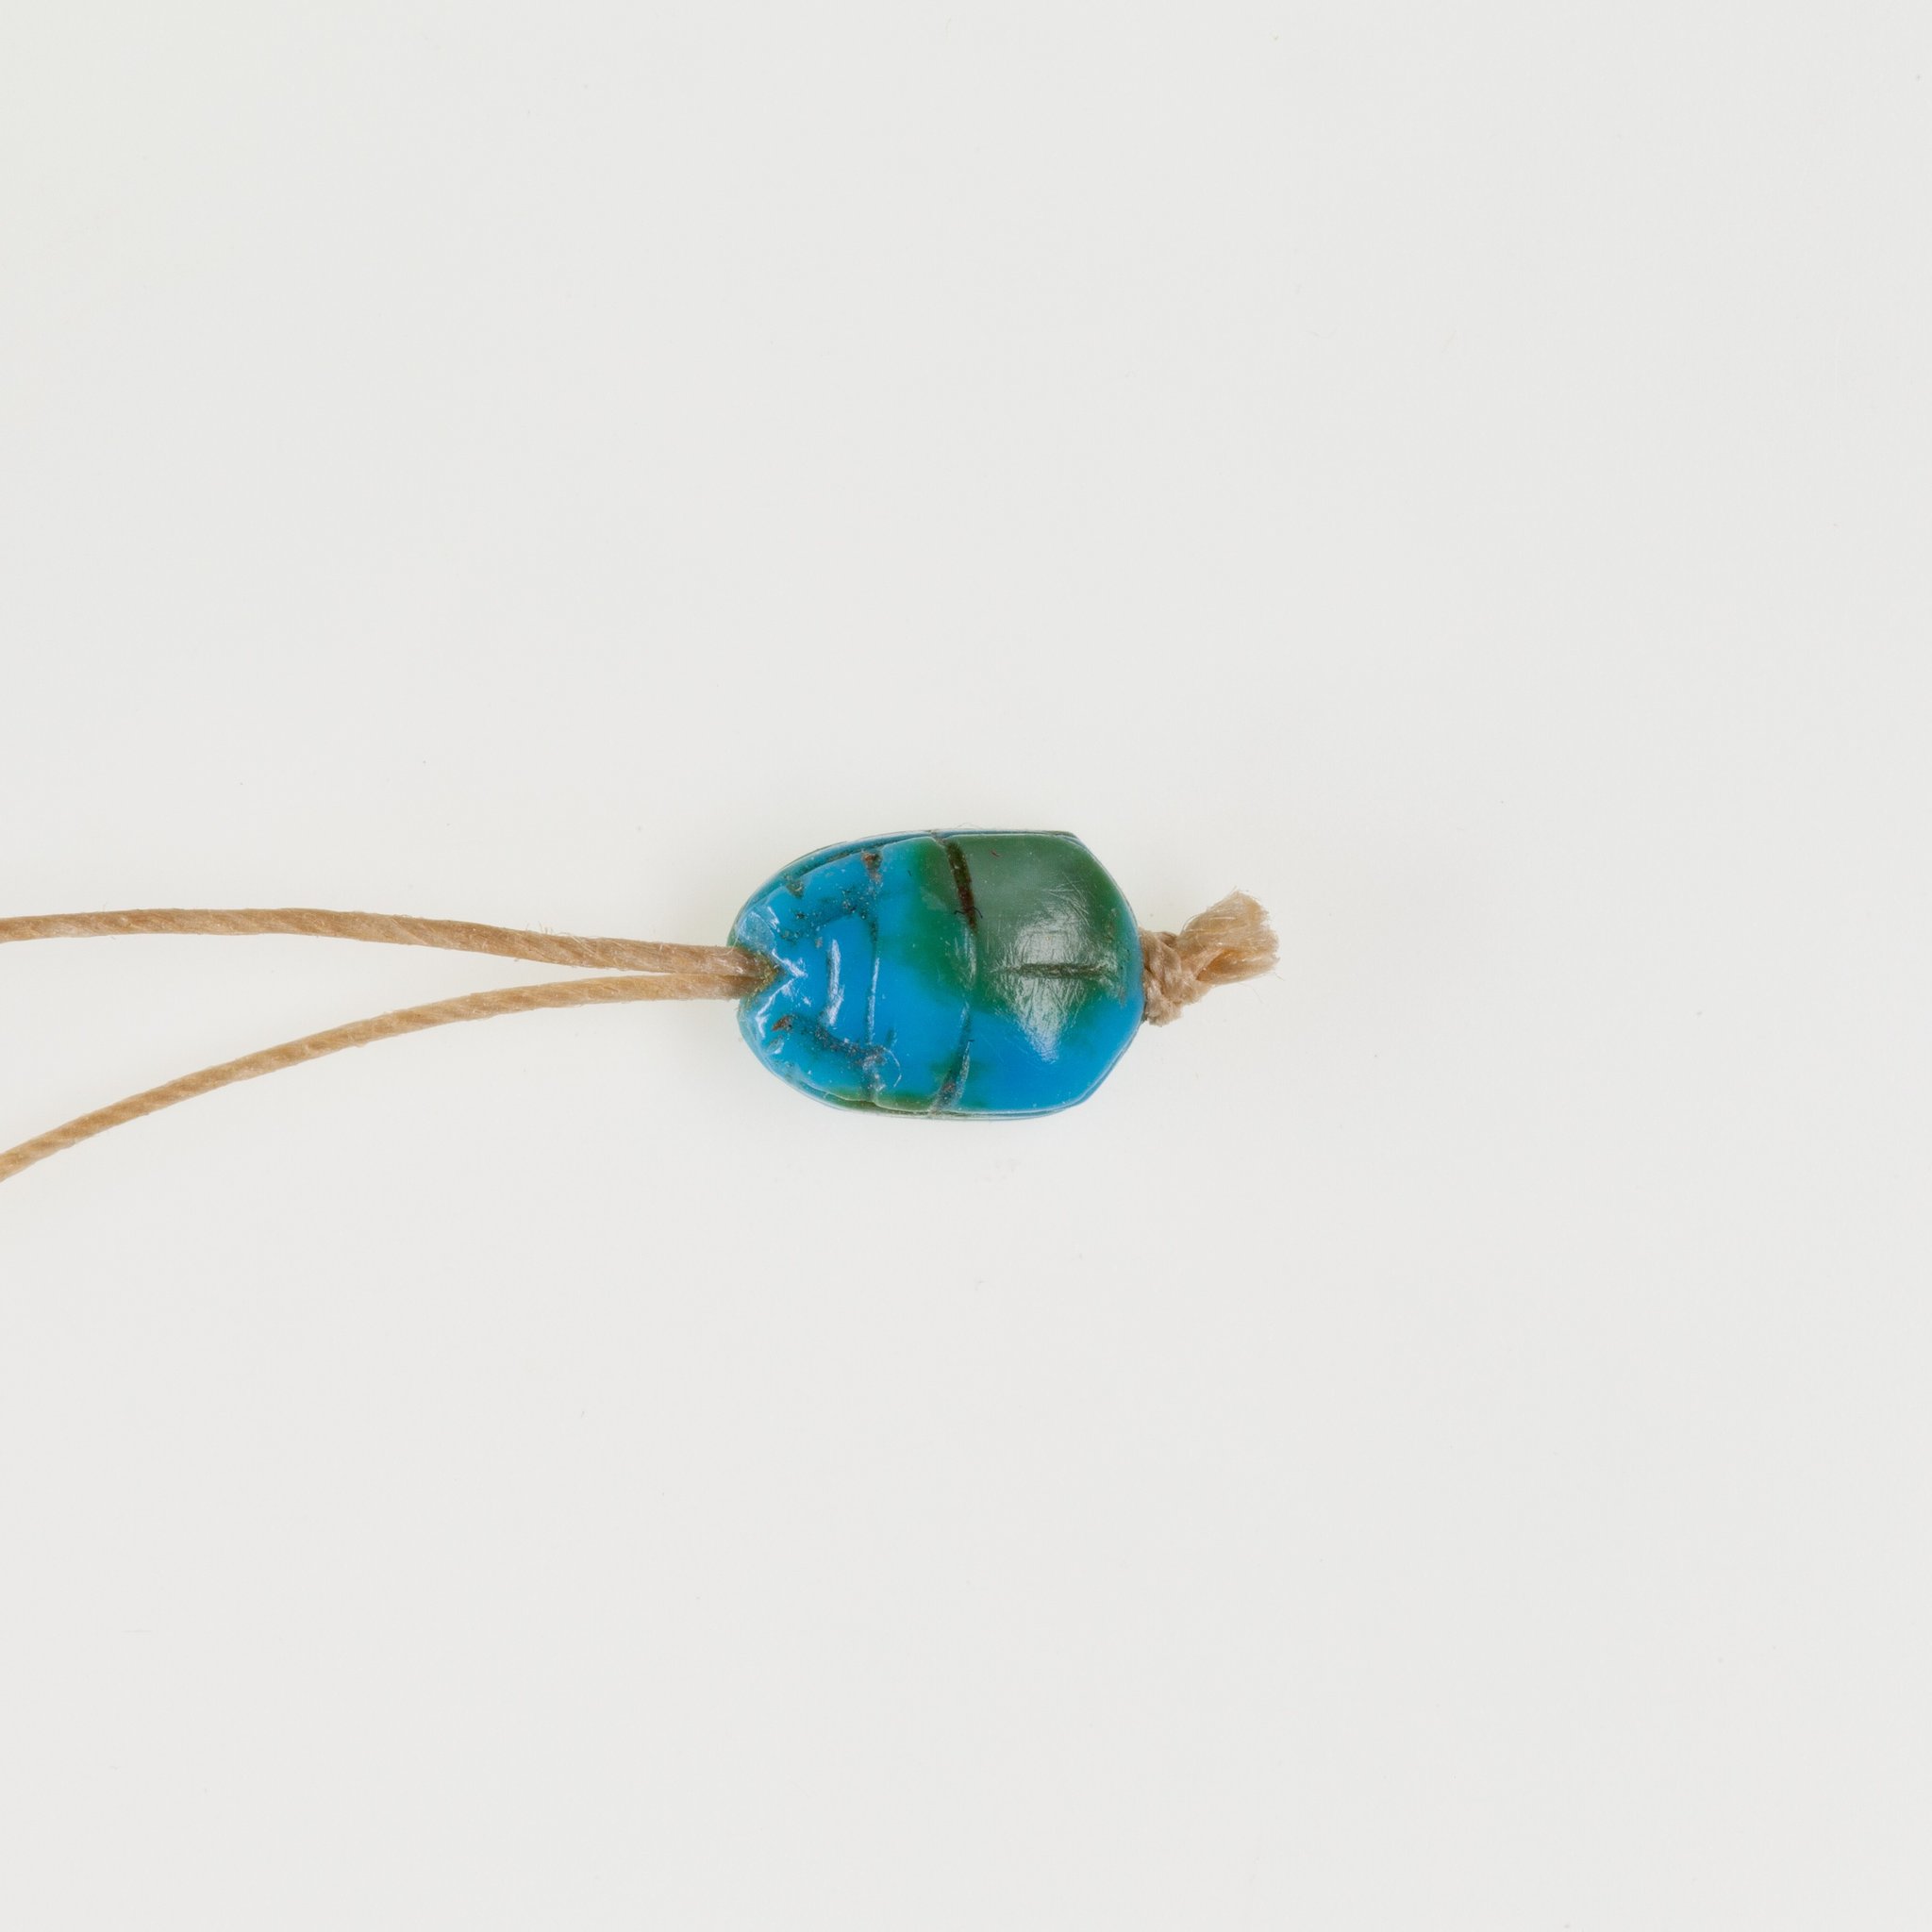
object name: scarab, uninscribed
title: Scarab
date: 1981-1550 BCE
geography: egypt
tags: scarabs